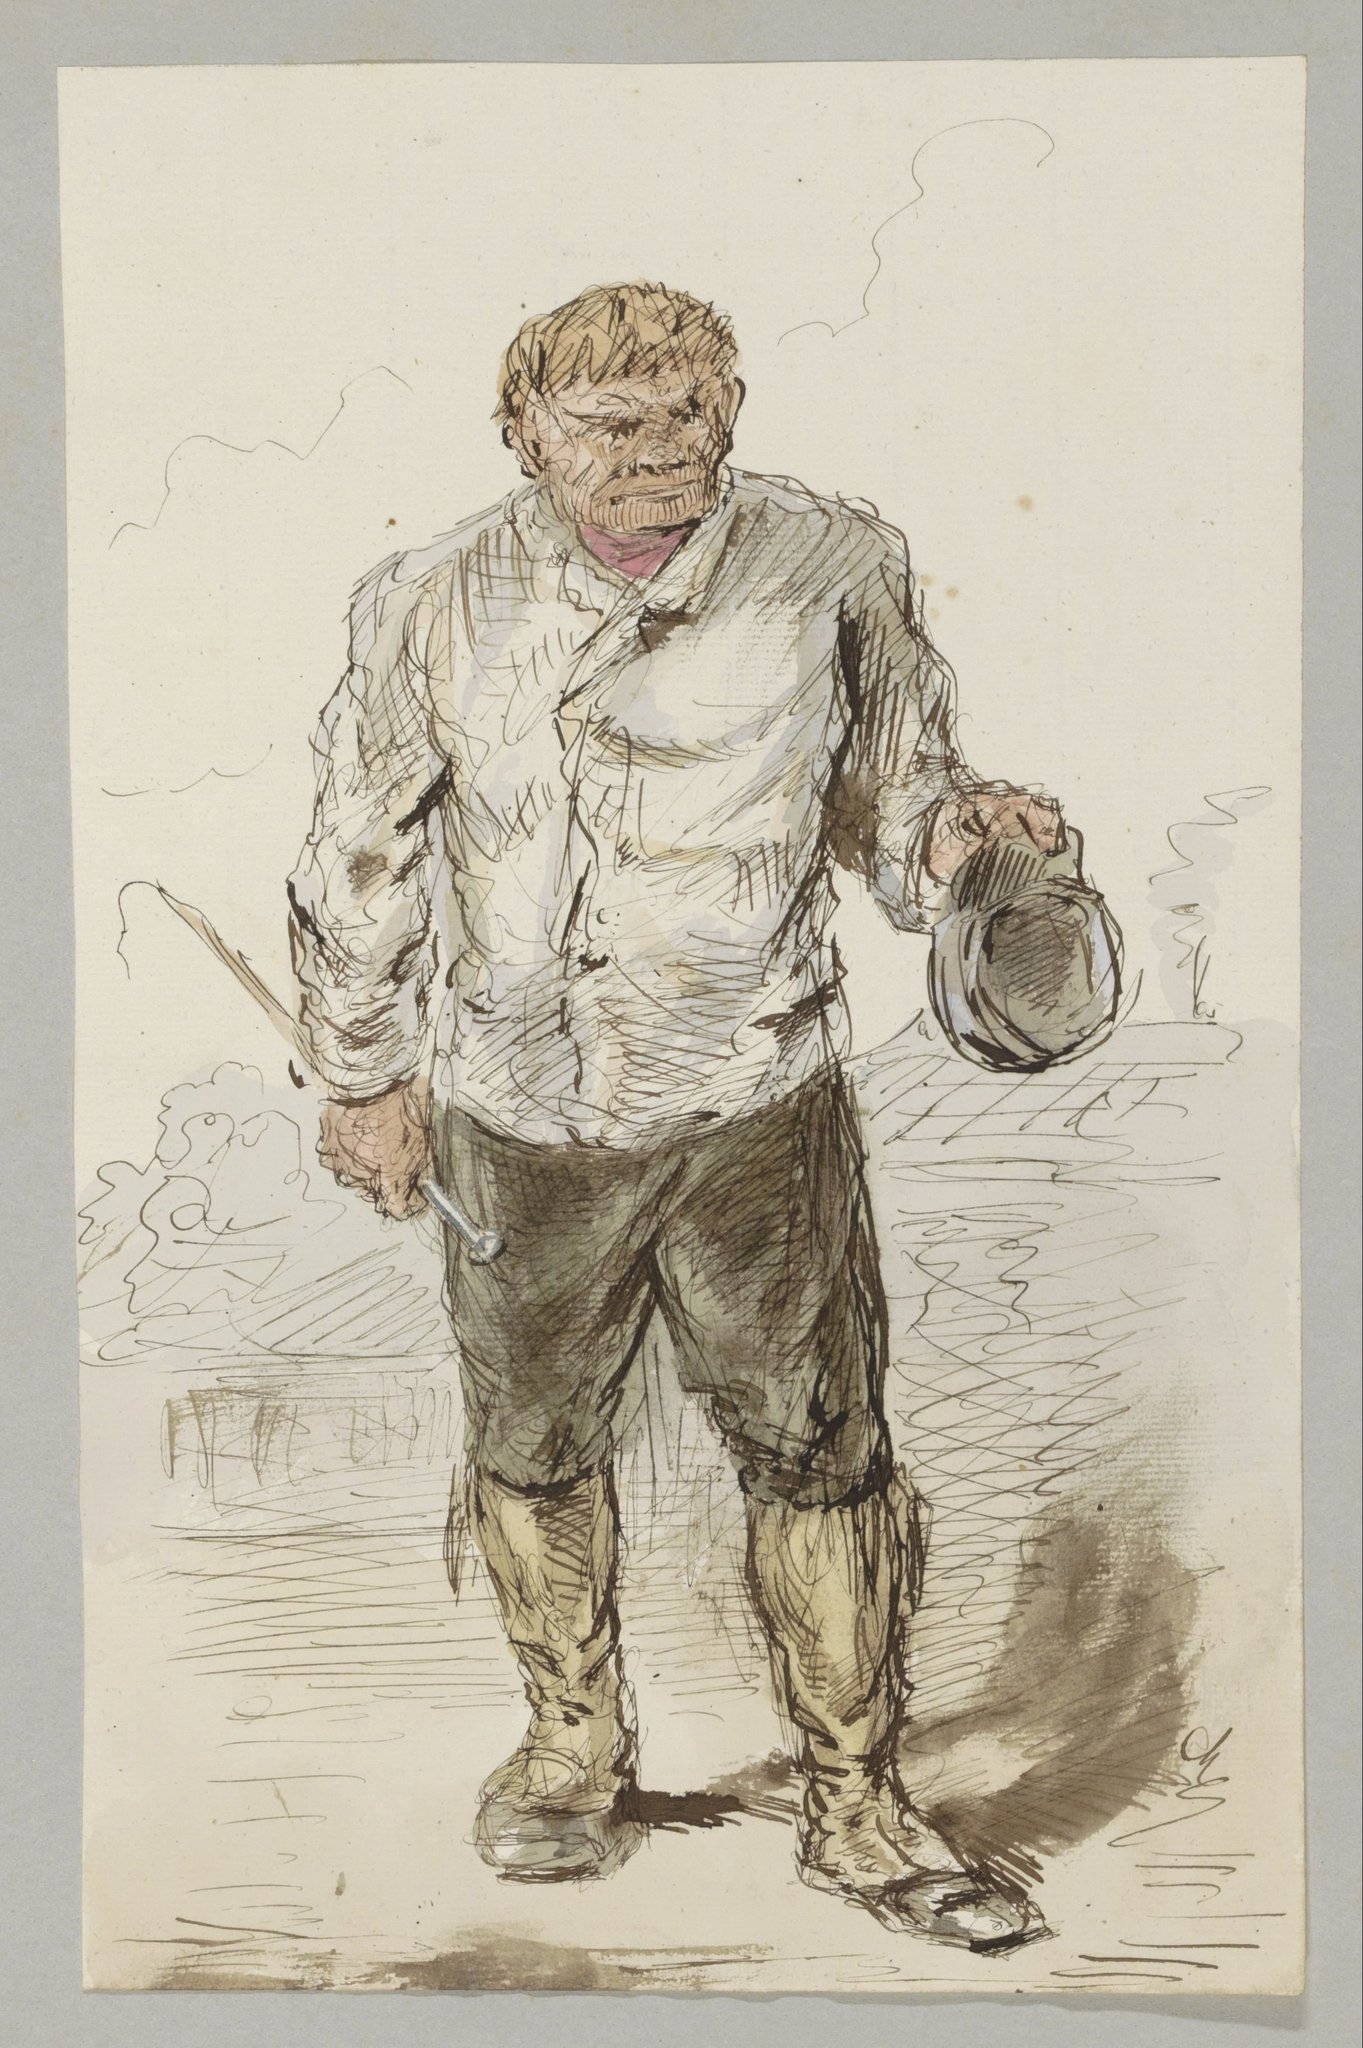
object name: drawing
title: Bedelaar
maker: alexander ver huell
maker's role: draughtsman, print maker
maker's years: 1822-1897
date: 1854-1887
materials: ink, paper, watercolor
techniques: brush, pen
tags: beggar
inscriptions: signature: ‘Avh’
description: Tekening 1 op blad 4 van een album met 35 tekeningen.